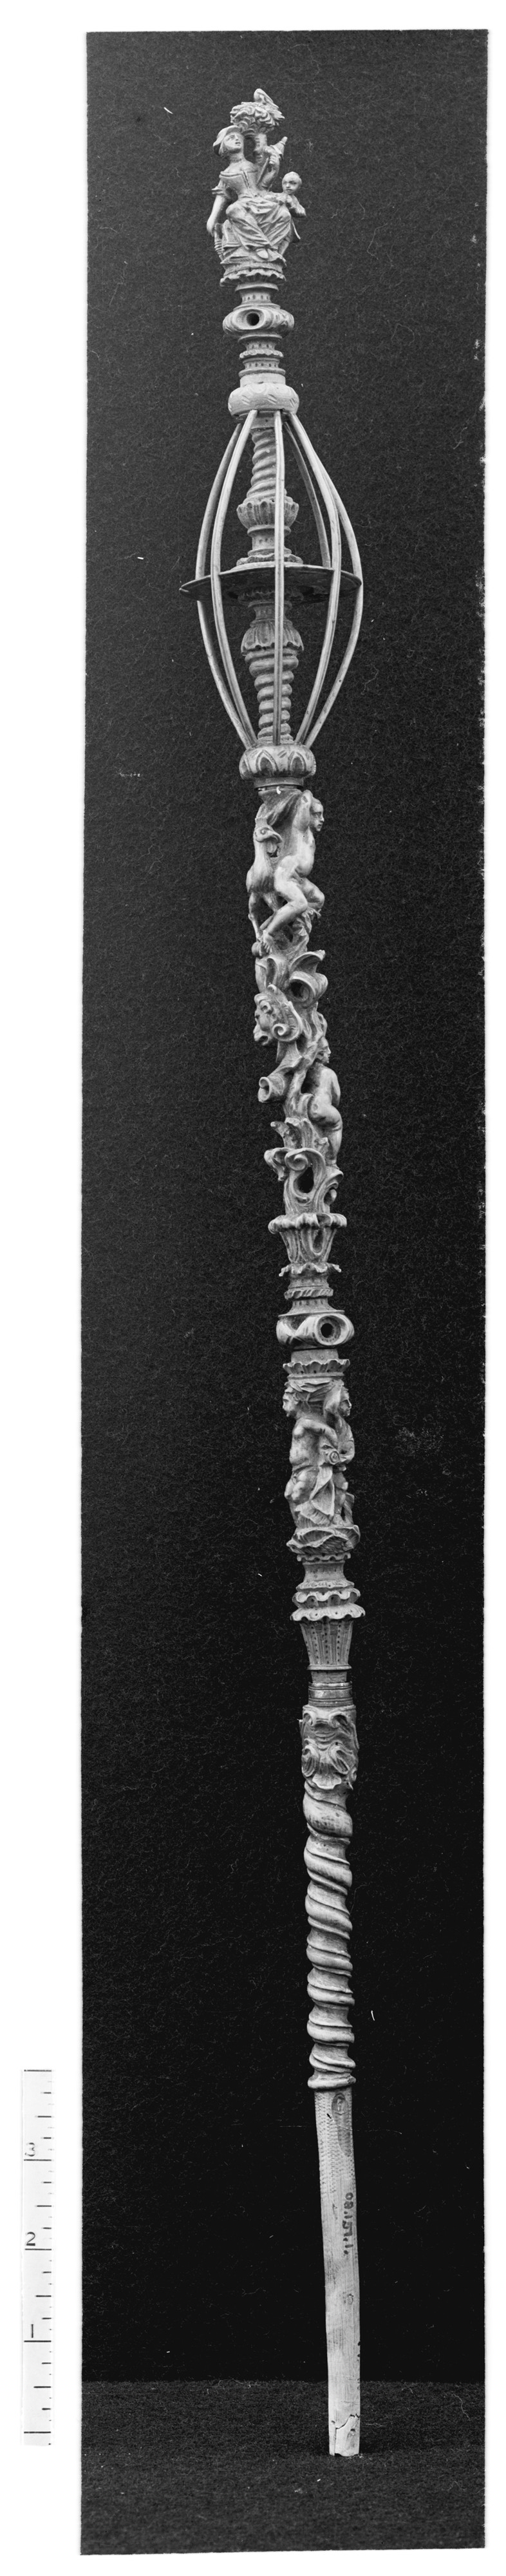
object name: spindle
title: Spindle (distaff)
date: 1701-1800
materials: wood